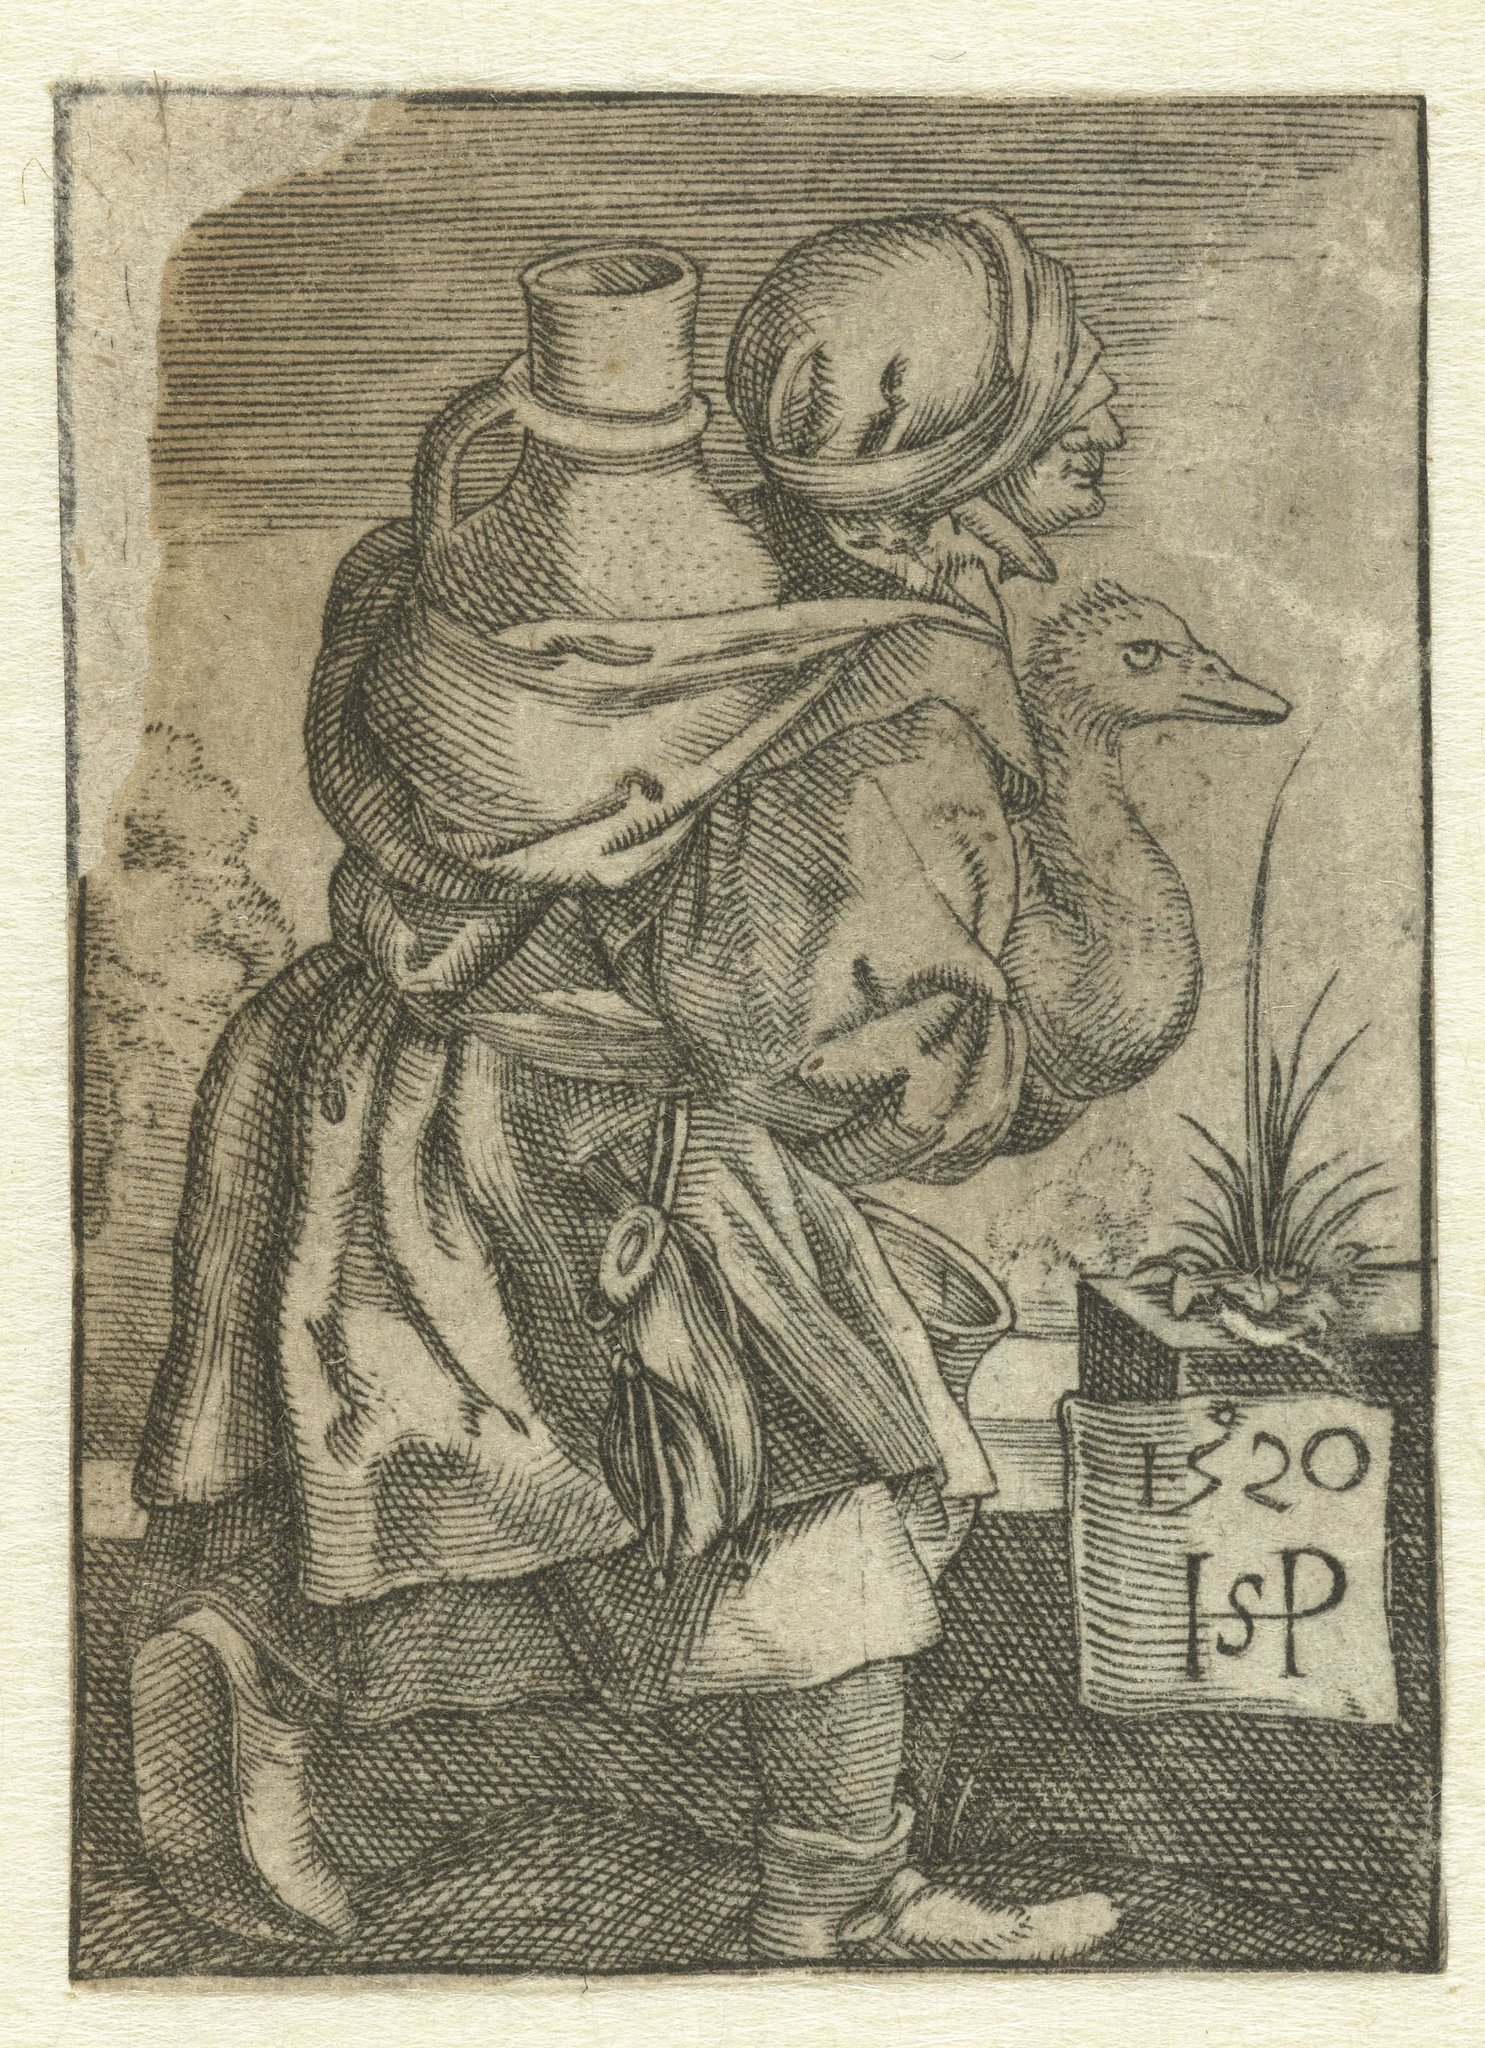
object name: print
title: Boerin op weg naar markt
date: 1520-1599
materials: paper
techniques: engraving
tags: going to the market, farmers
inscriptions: collector's mark: Lugt 2228a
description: Kopie in spiegelbeeld naar prent van Hans Sebald Beham